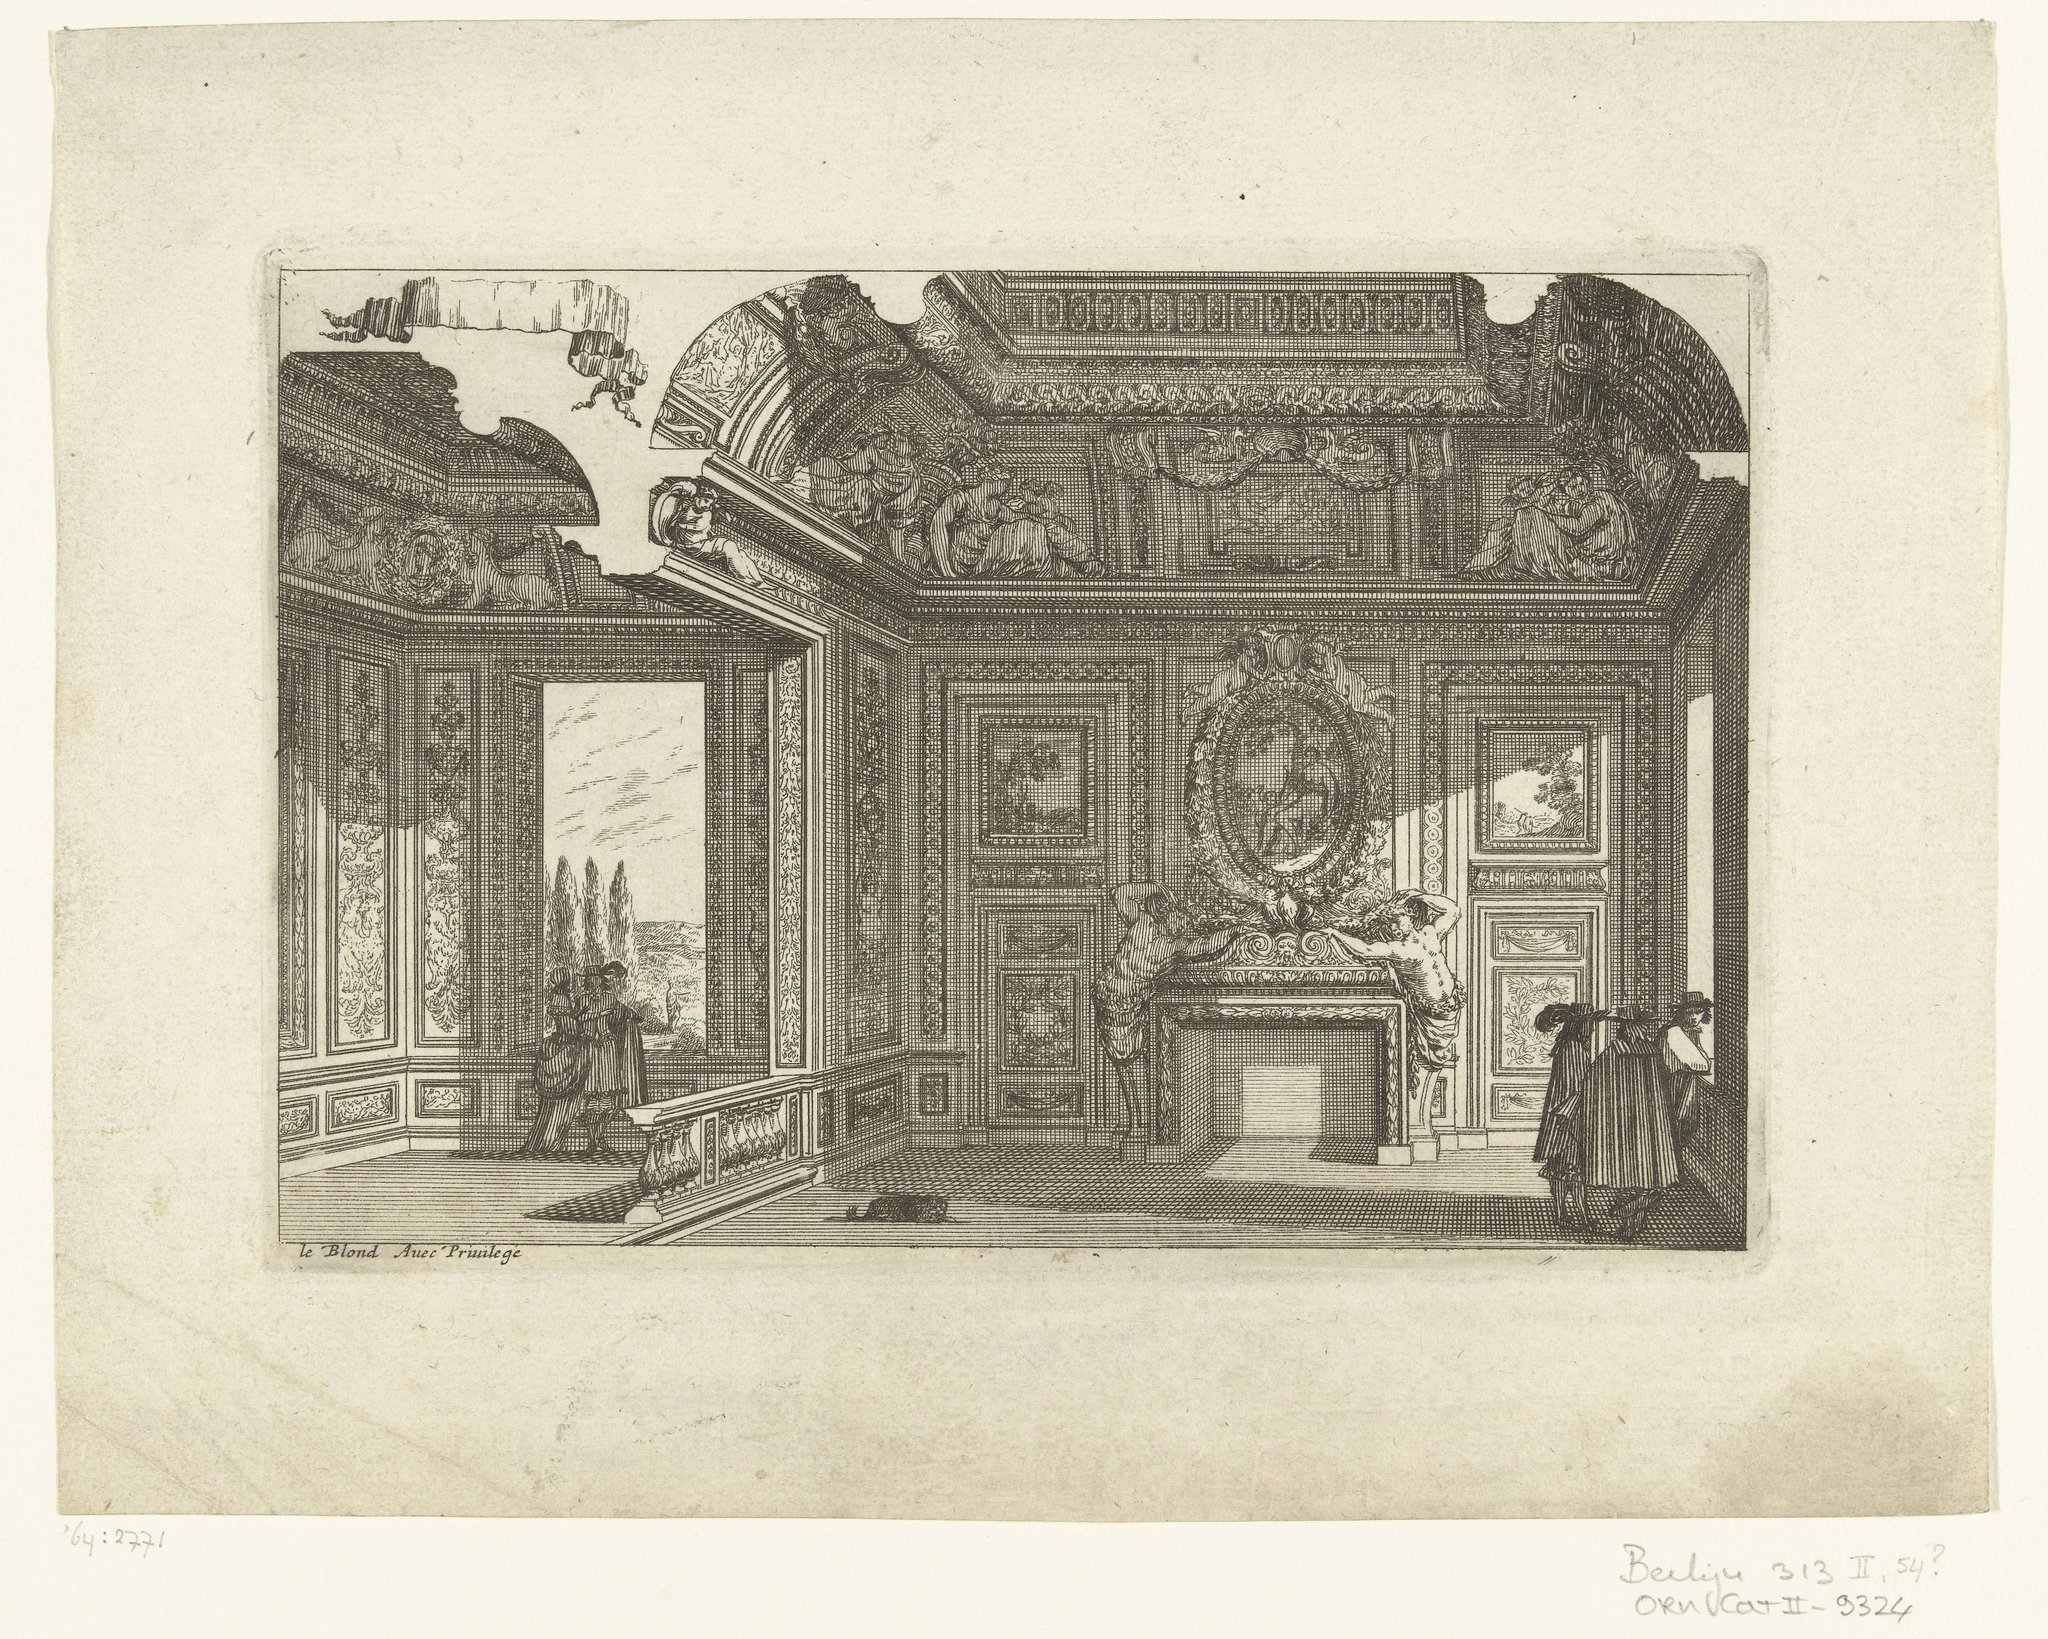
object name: print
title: Plafonds modernes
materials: paper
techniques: etching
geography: france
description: In de kamer bevindt zich een onderboezem, met een herme aan weerszijden en erboven een ovaal schilderij van Diana. Uit serie van 12.